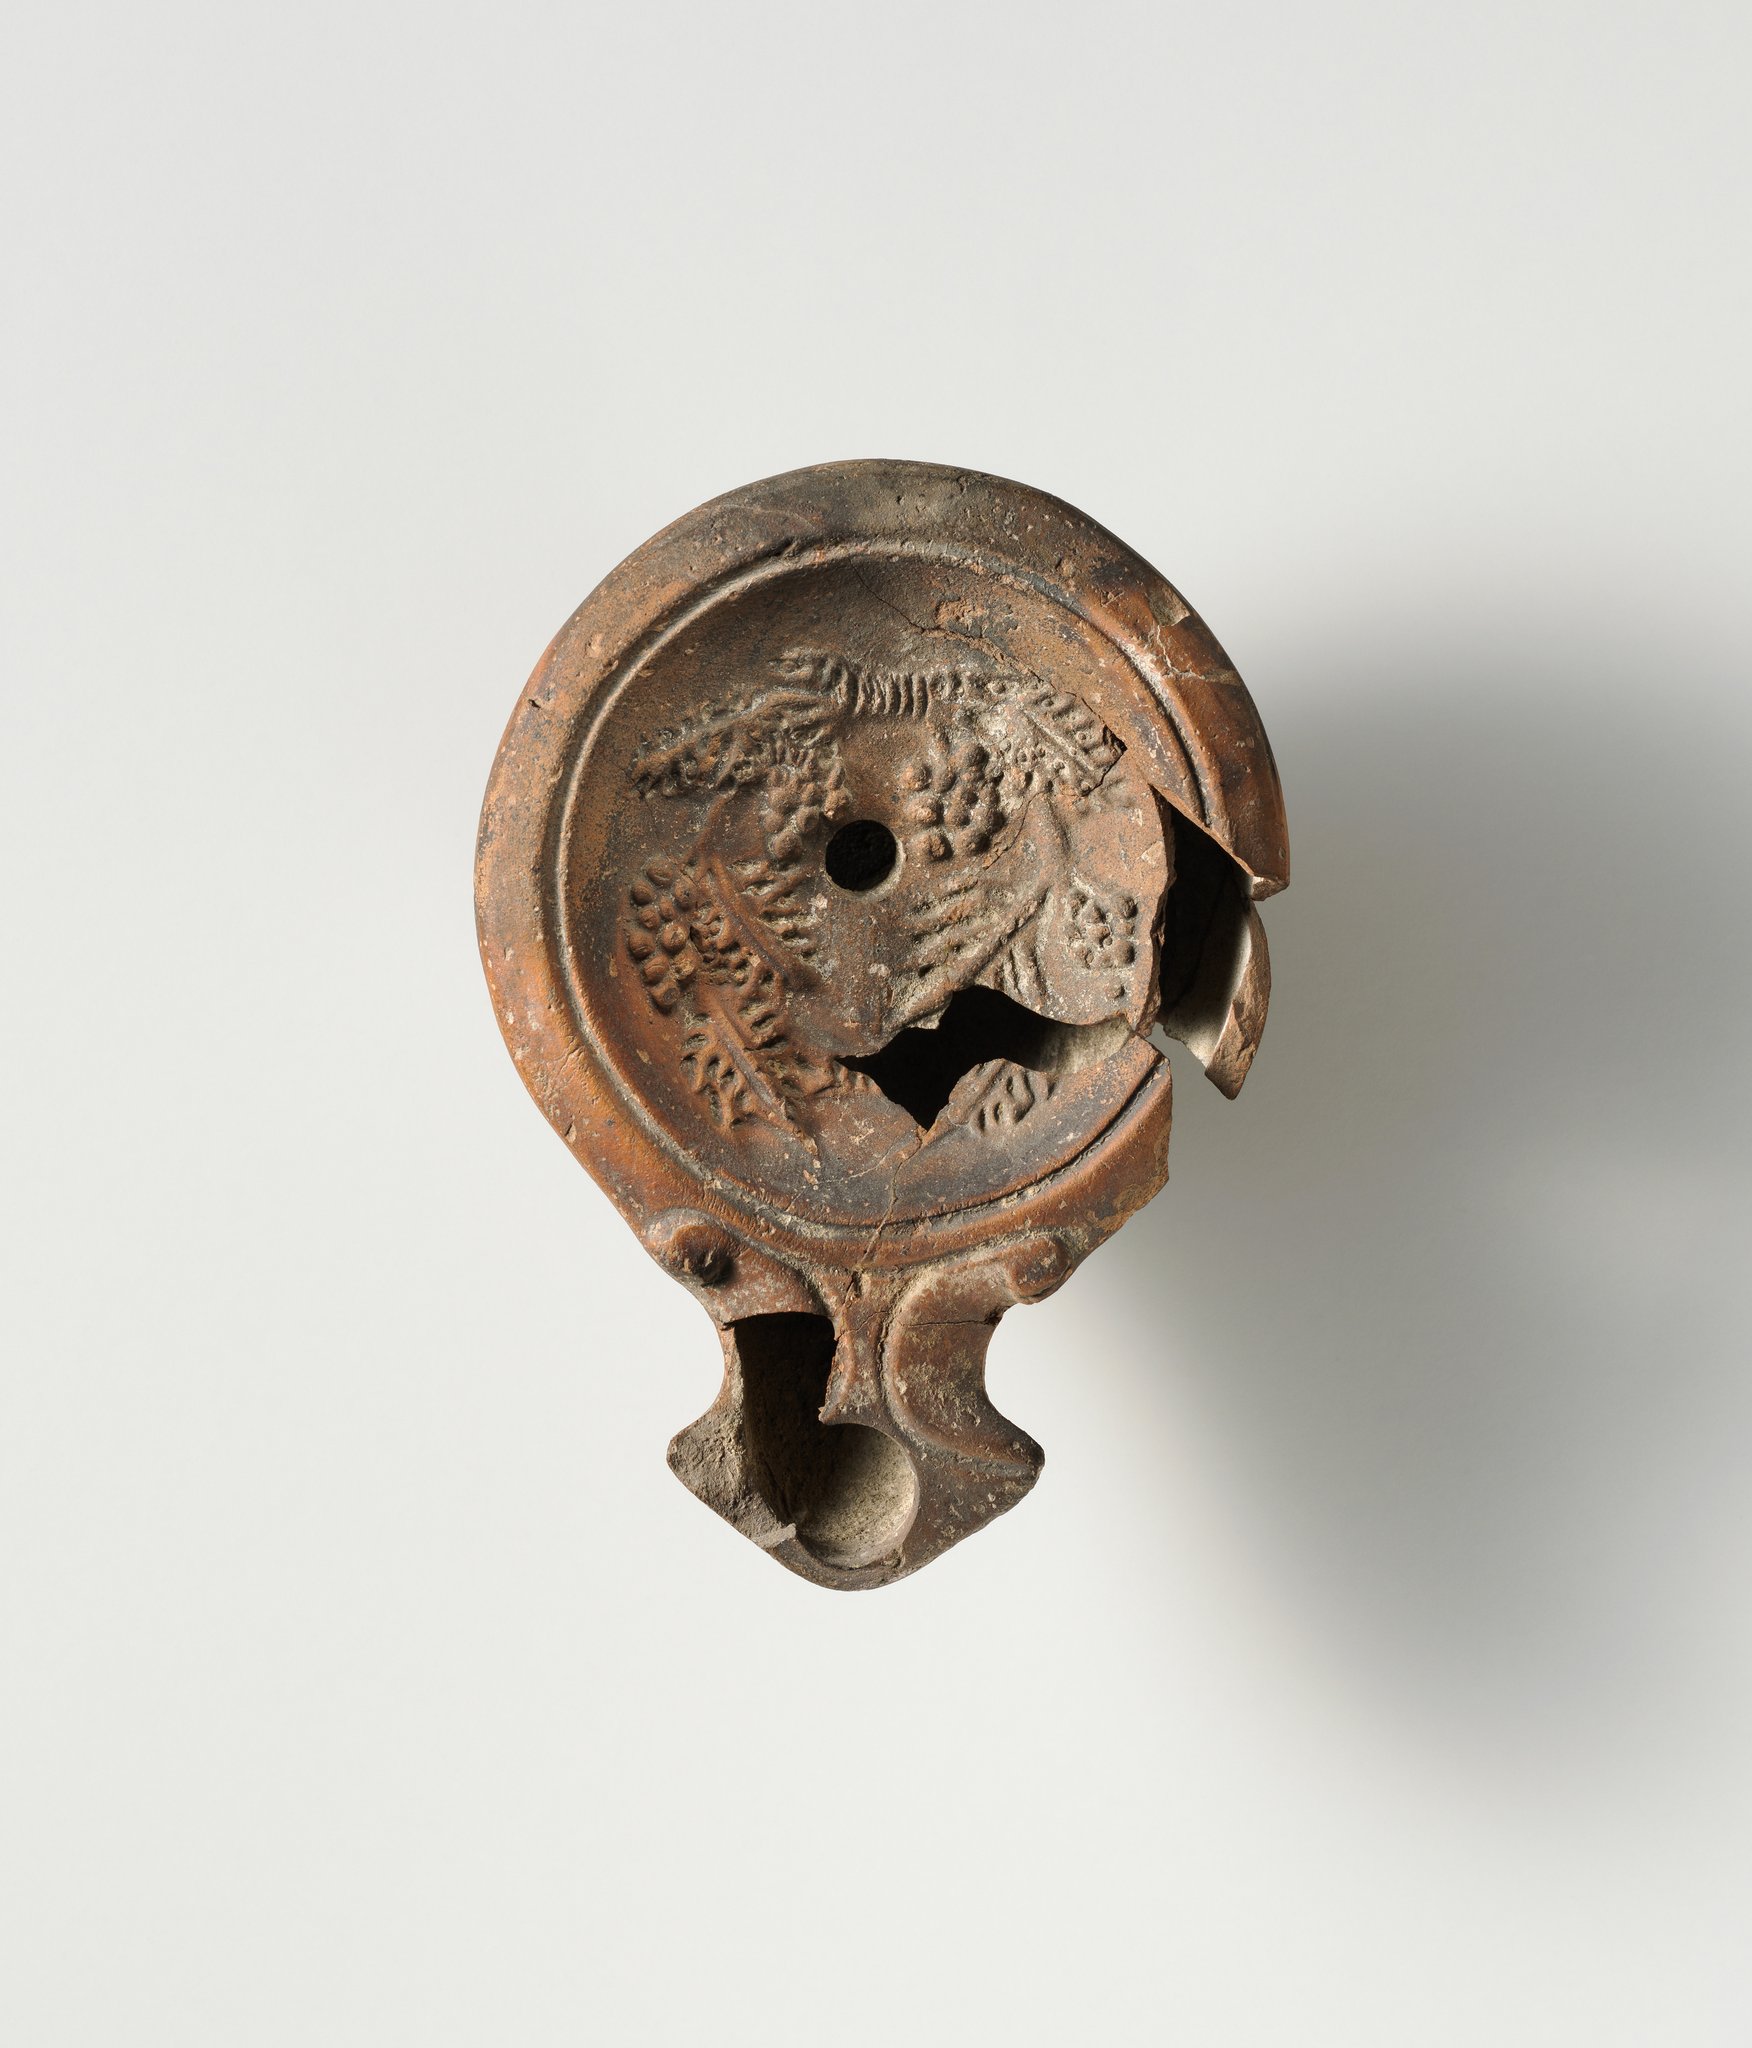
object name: lamp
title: Terracotta oil lamp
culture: roman, cnidian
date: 1-33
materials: terracotta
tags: grapes